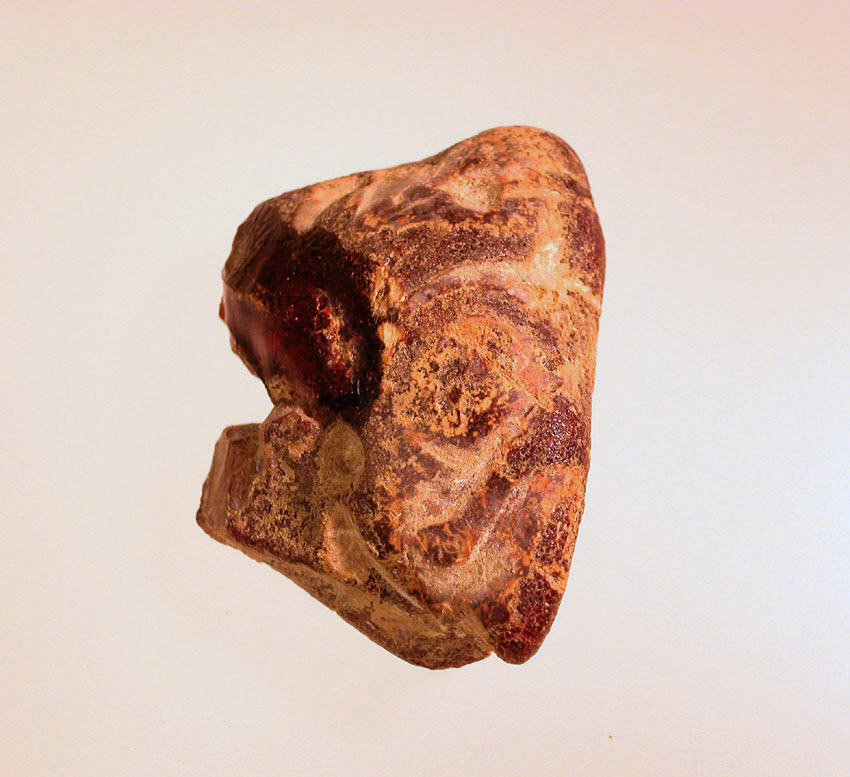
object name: head of a satyr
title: Pendant: satyr's head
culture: italic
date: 500-401 BCE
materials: amber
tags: satyrs